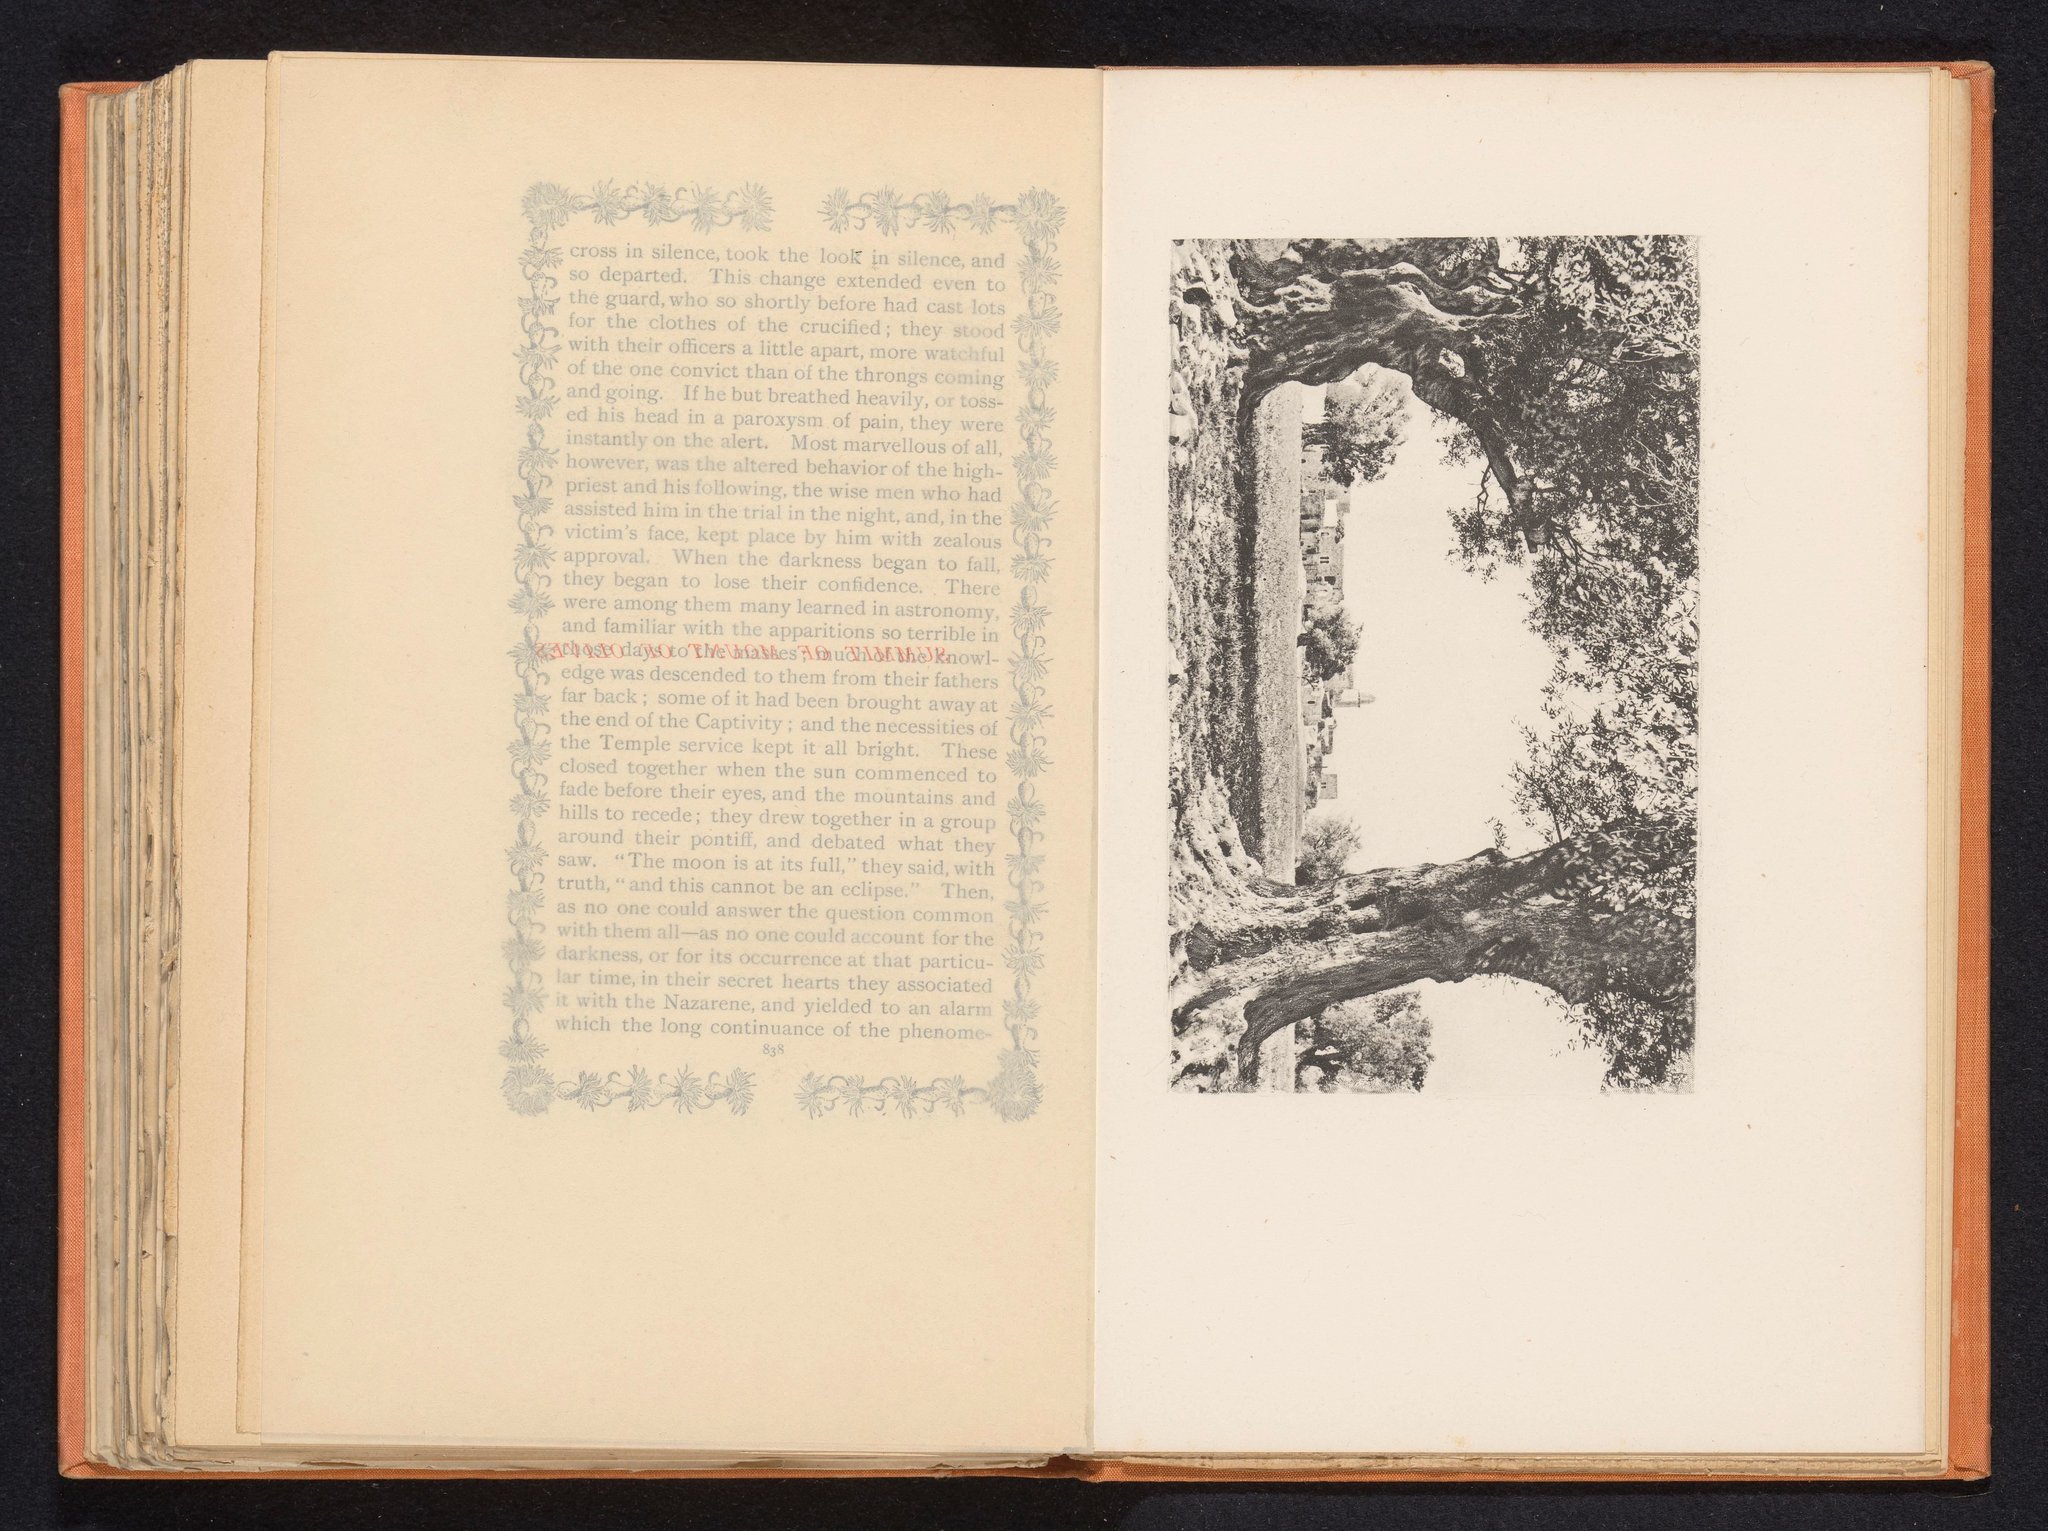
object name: photomechanical print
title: Bomen en gebouwen op de top van de Olijfberg bij Jeruzalem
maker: Anonymous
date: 1882-1892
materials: paper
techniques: photoaquatint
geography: jerusalem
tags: mountains